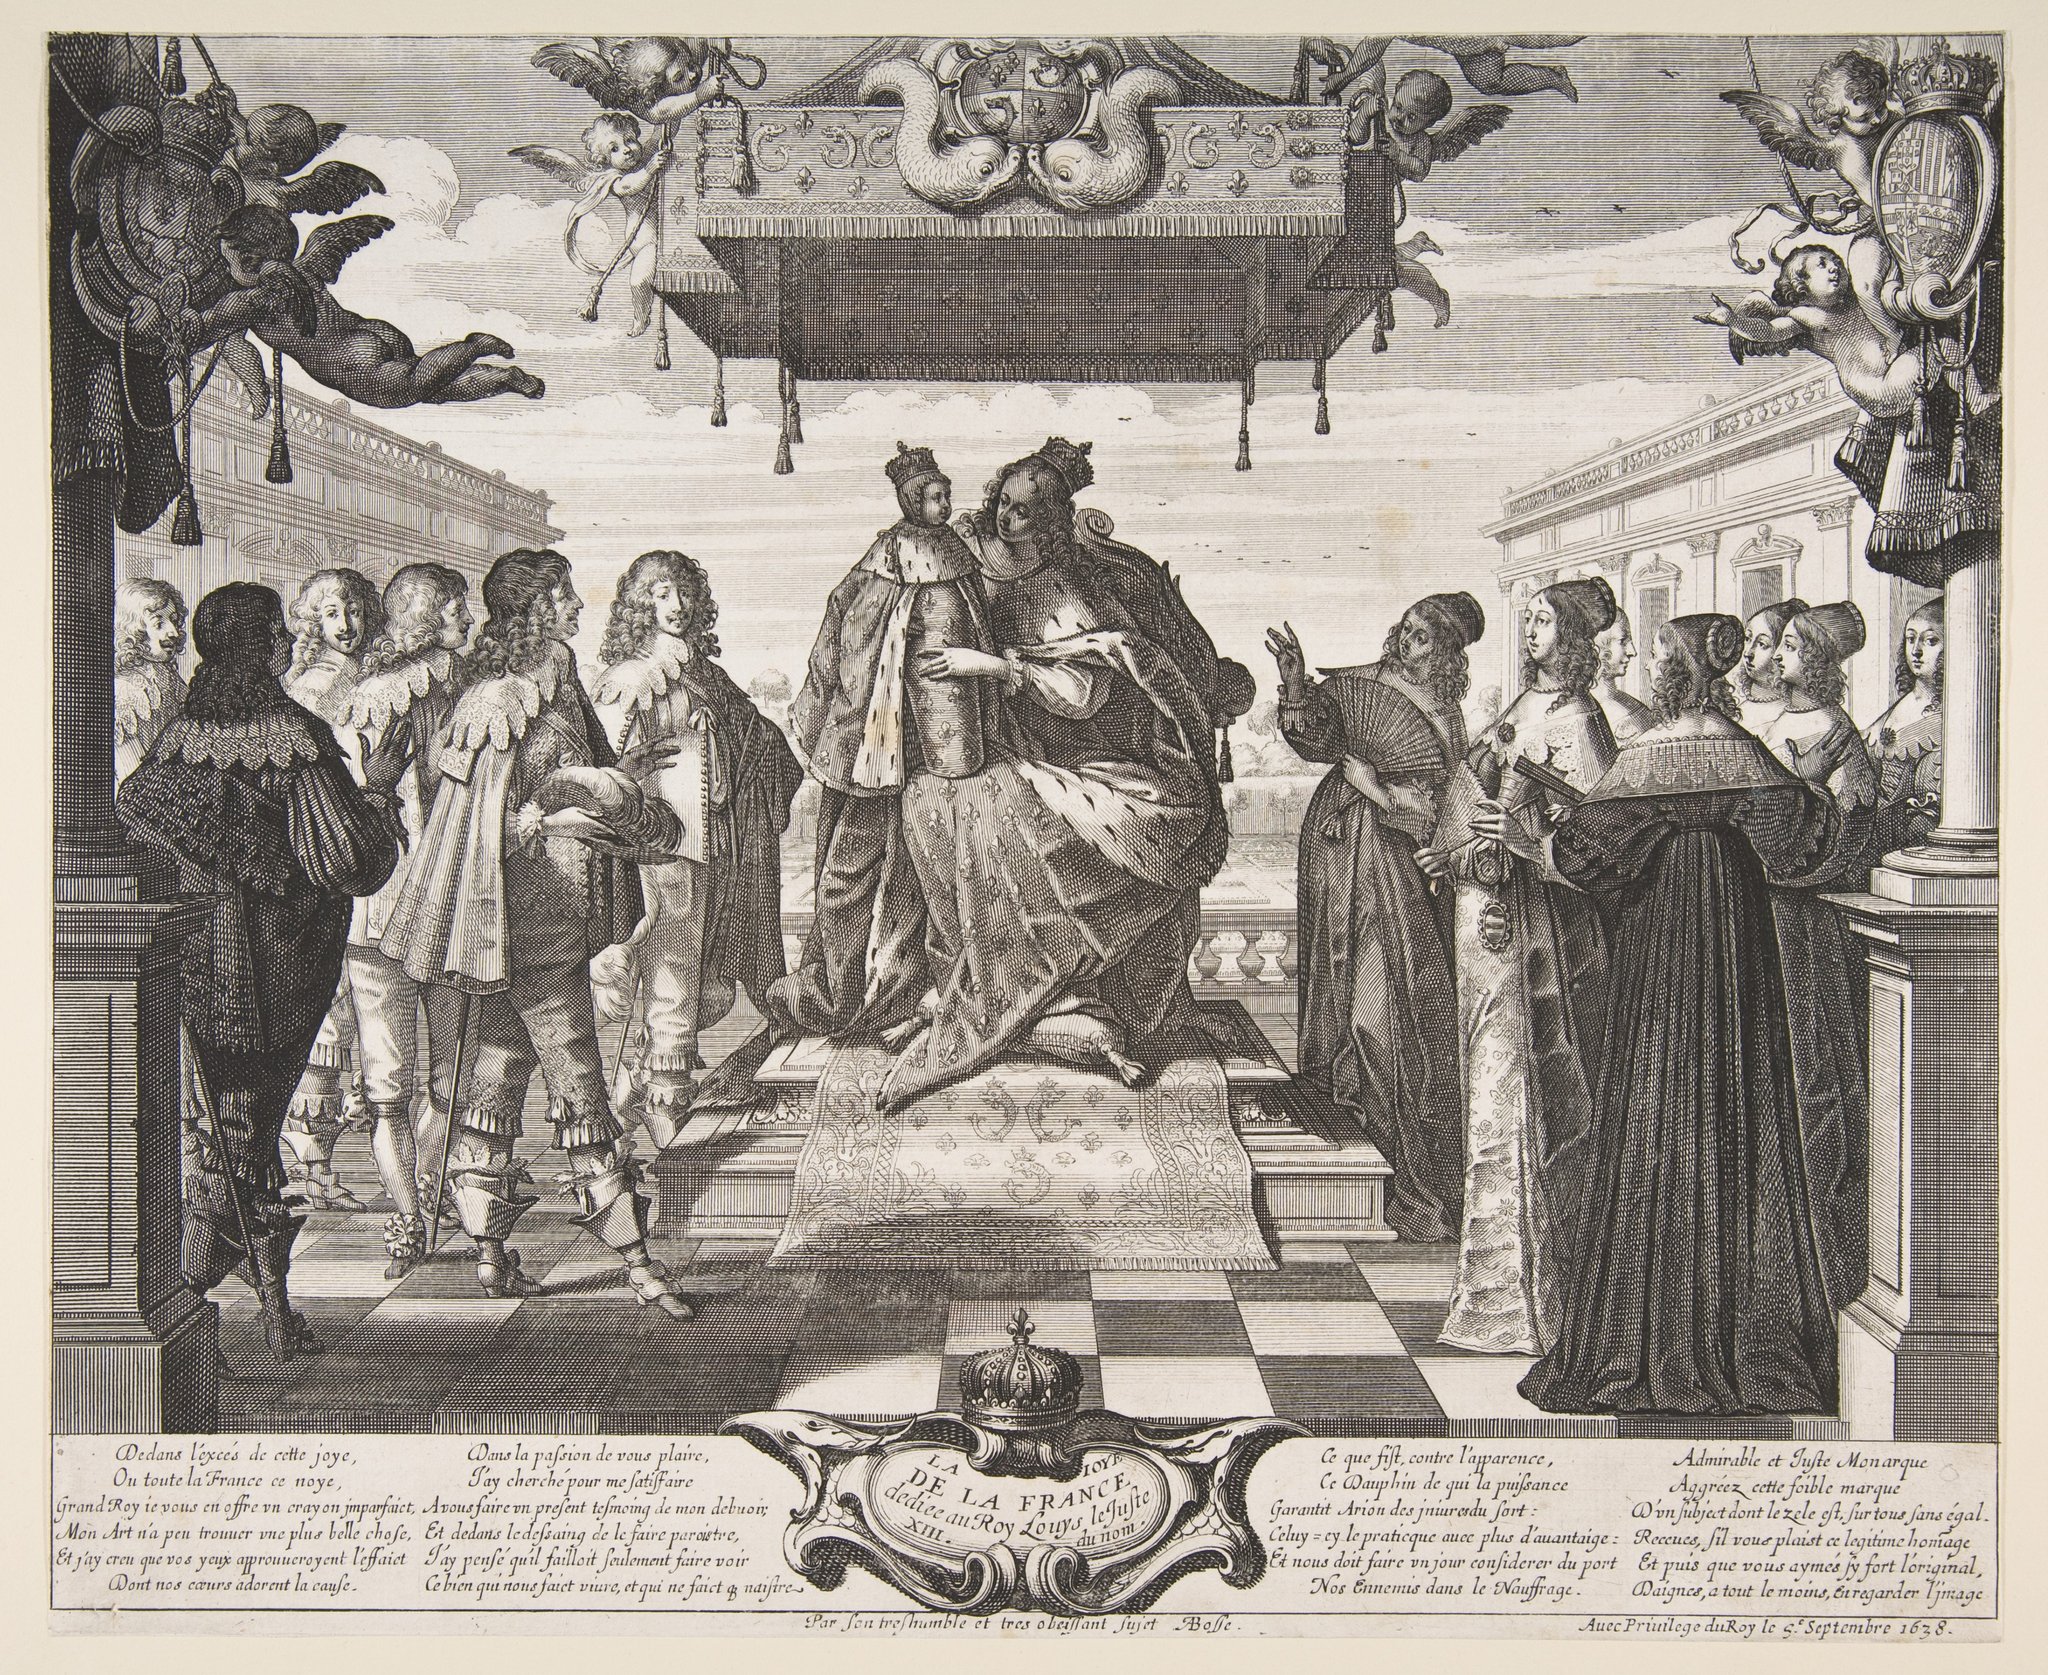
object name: print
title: The Joy of France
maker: abraham bosse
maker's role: artist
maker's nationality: french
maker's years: 1602-1676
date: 1638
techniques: etching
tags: men,women